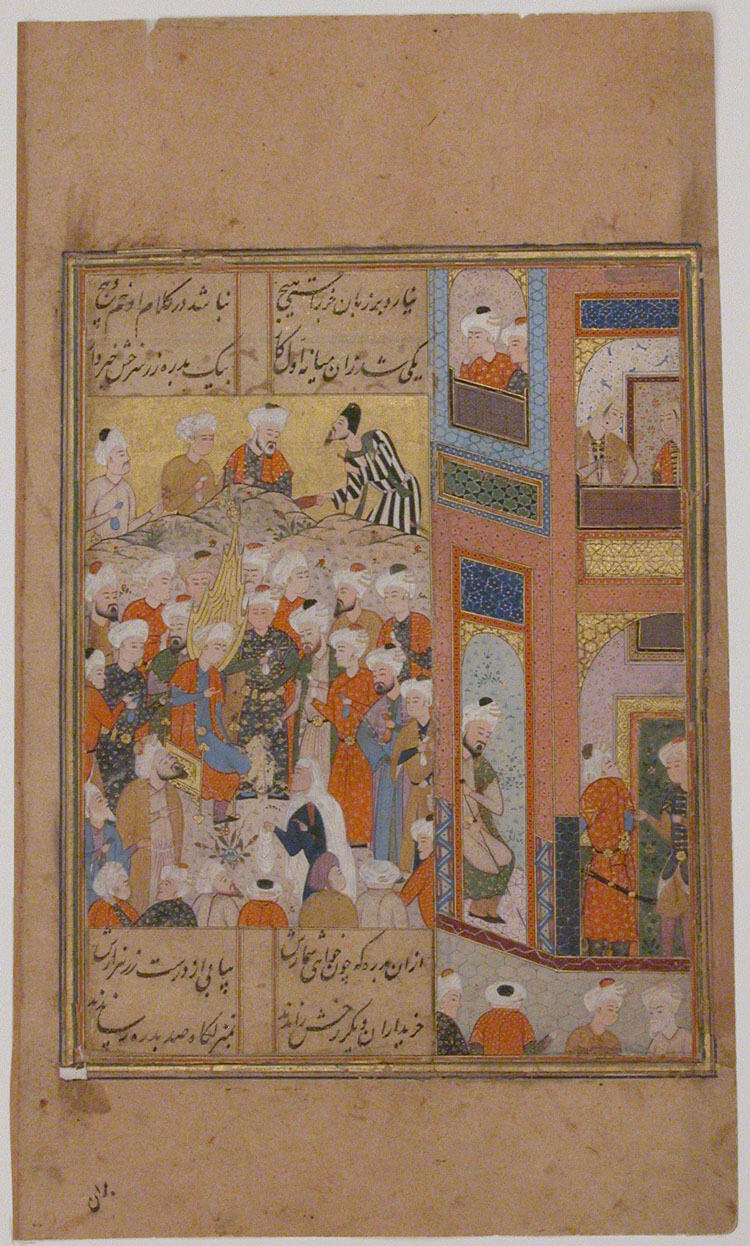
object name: folio from an illustrated manuscript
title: "Yusuf is Purchased by Zulaykha", Folio from a Yusuf and Zulaykha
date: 1501-1600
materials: gold, ink, paper, watercolor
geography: iran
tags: men